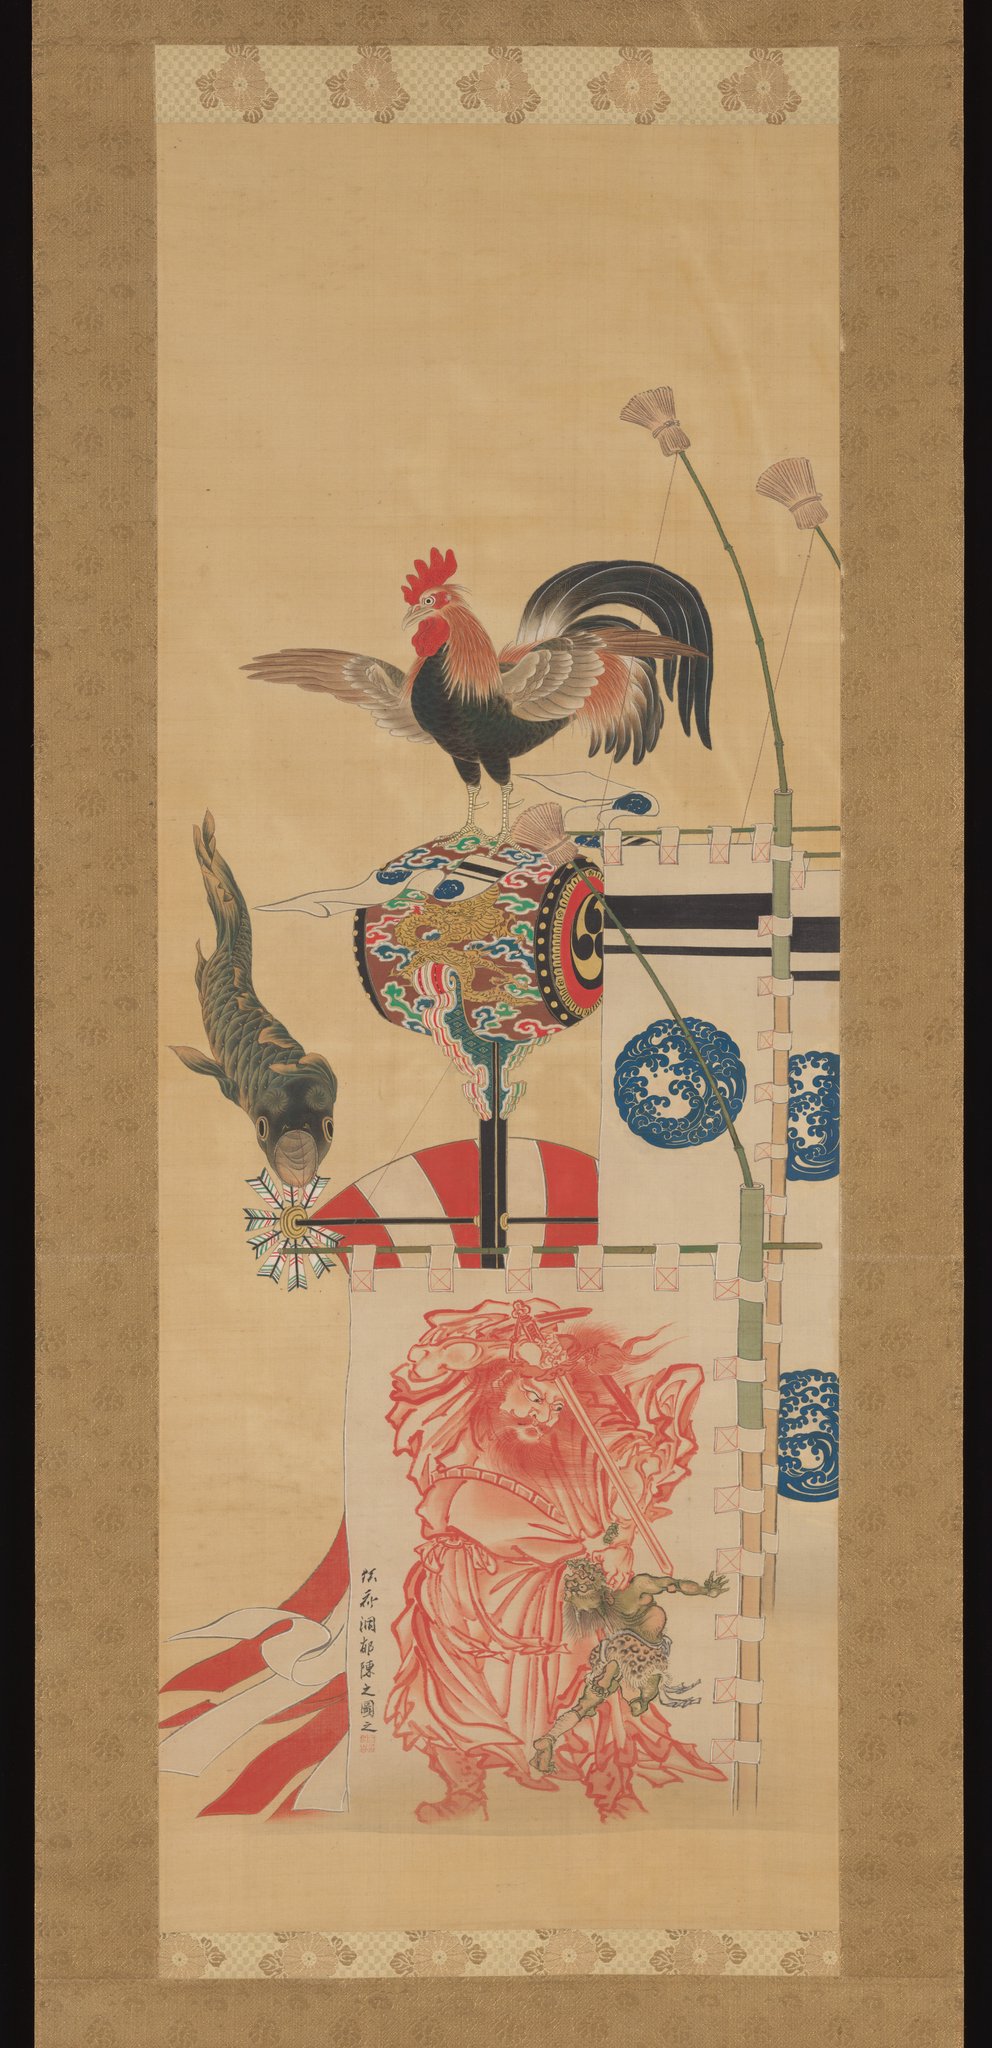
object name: hanging scroll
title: Boy’s Day Carp Streamer and Shōki Banner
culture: japanese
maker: kawanabe kyōsai 河鍋暁斎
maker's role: artist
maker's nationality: japanese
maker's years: 1831-1889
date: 1870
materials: ink, silk